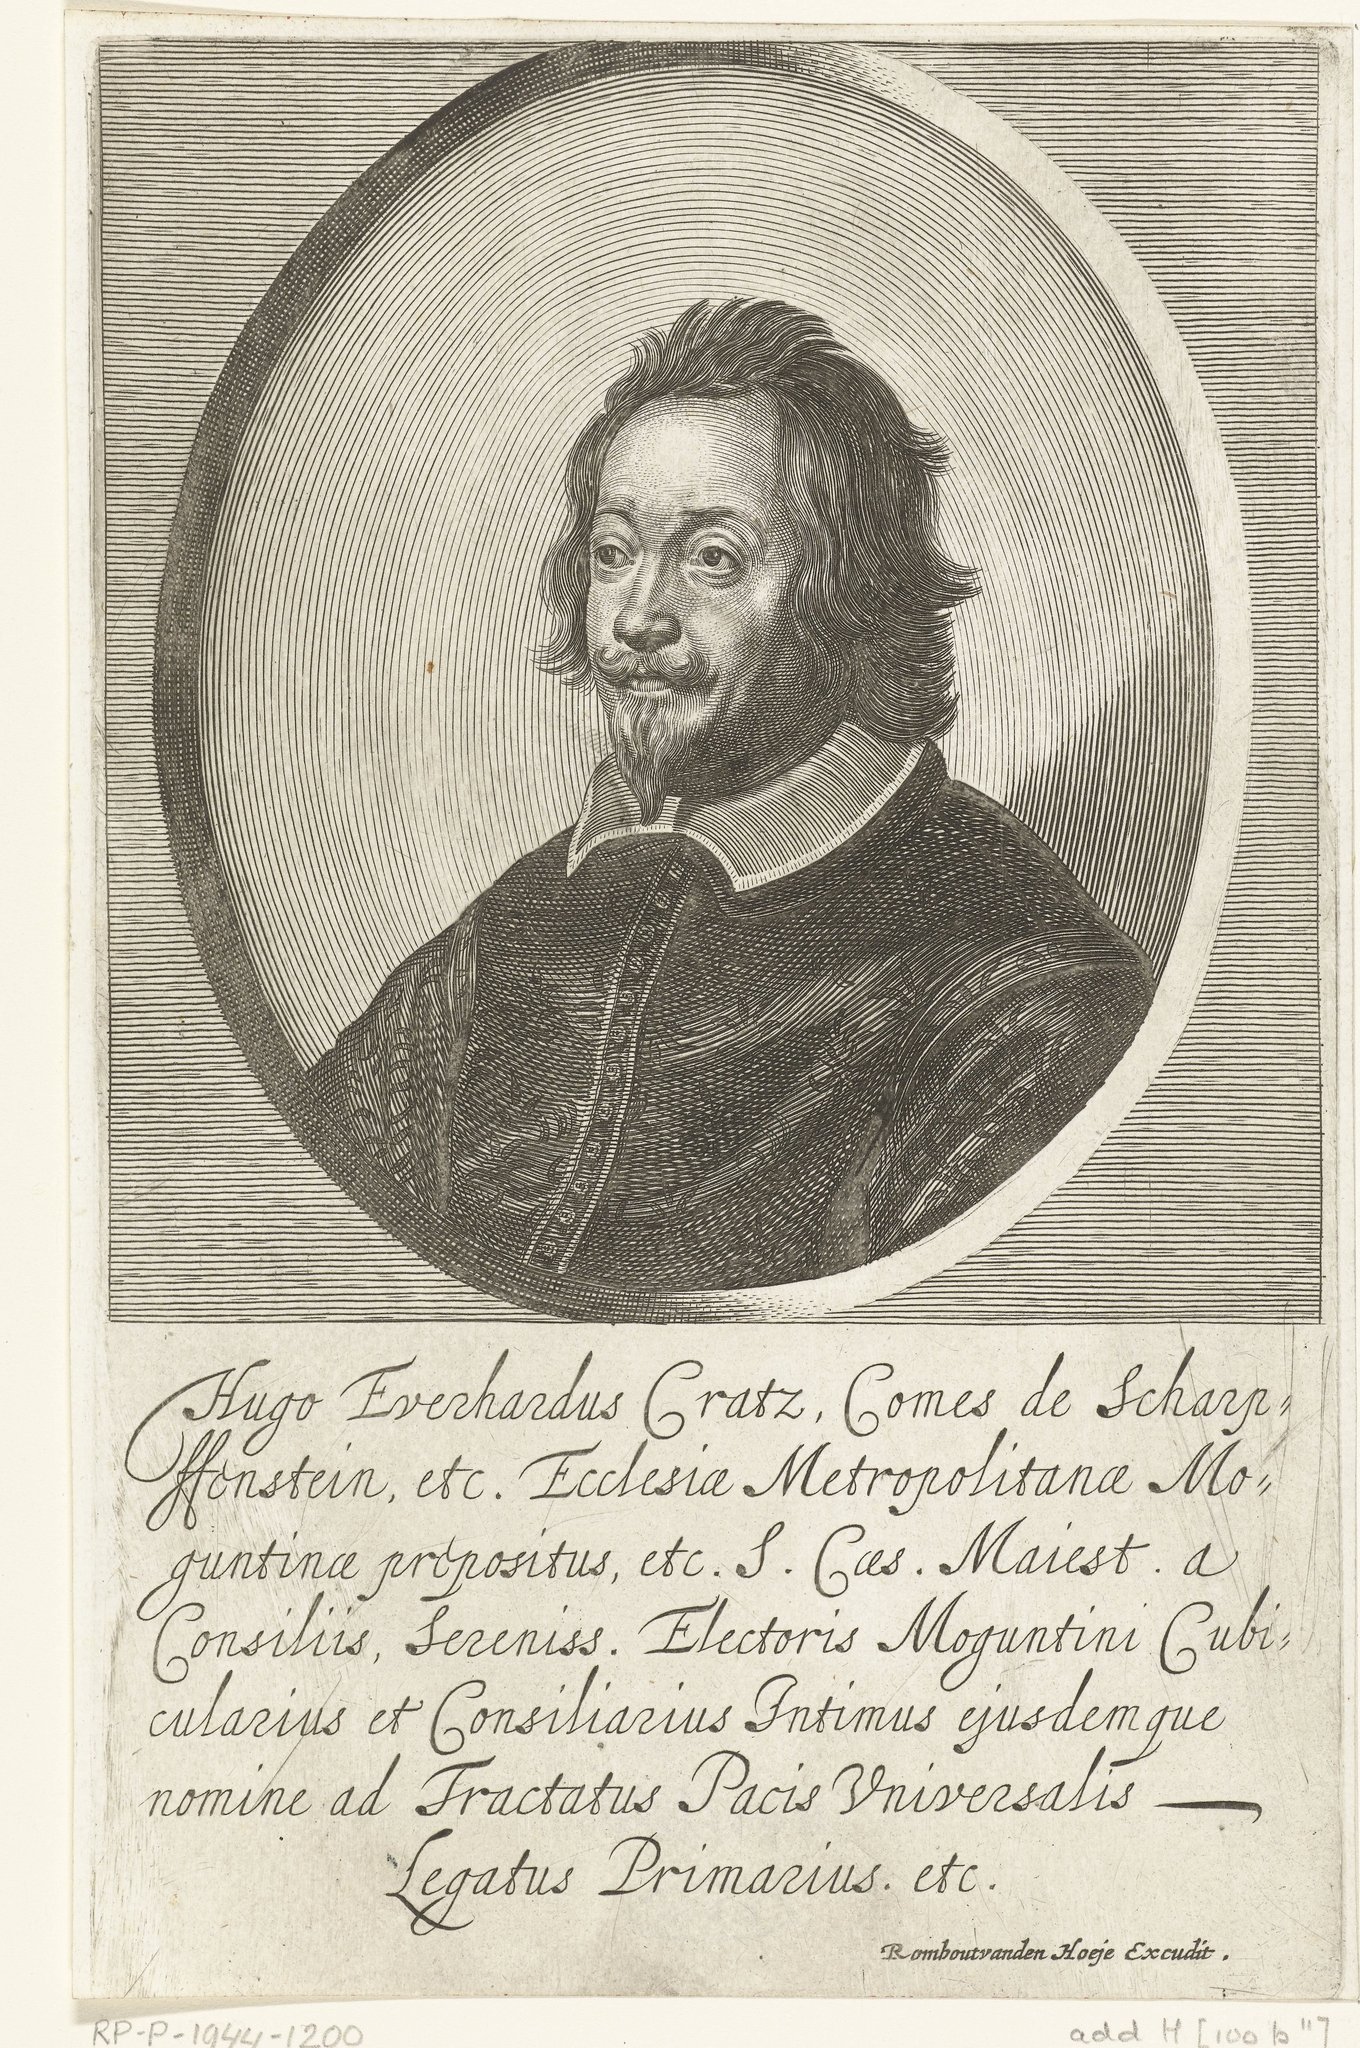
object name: print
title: Portret van Hugo Everhard Cratz graaf van Scharfenstein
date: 1623-1660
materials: paper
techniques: engraving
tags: bisschop, diplomaat, hugo everhard cratz (graaf van scharfenstein)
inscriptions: collector's mark: Lugt 2228